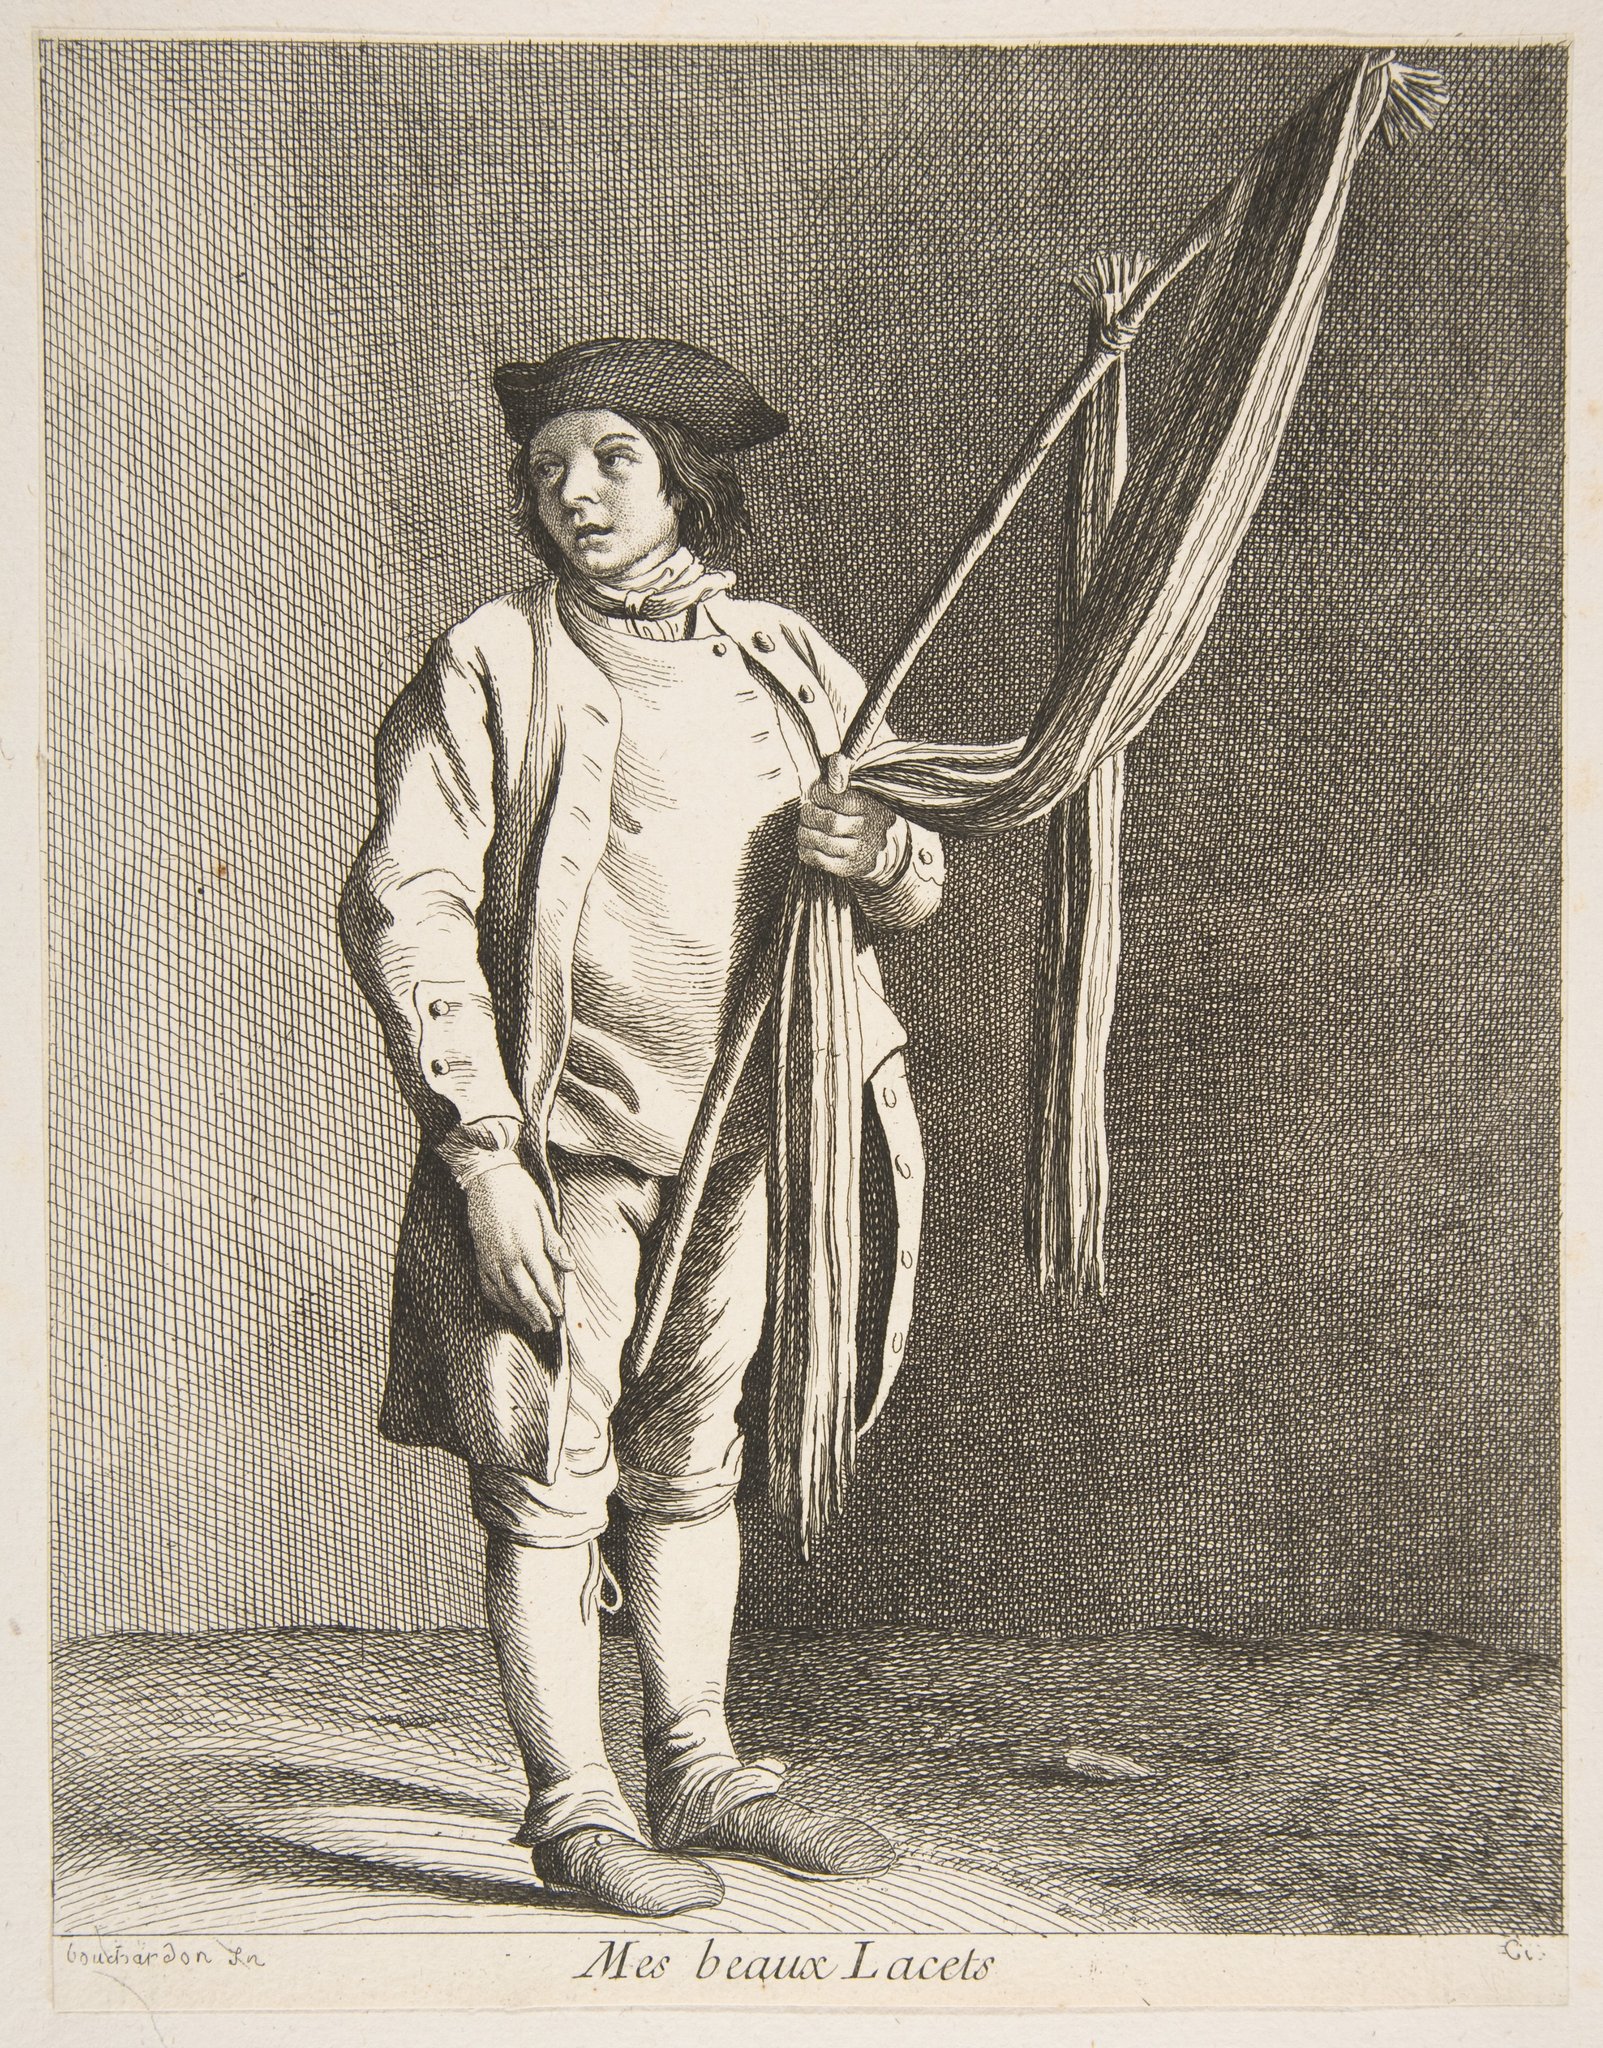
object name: print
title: Laces Peddler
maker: anne claude philippe de tubières, comte de caylus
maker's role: artist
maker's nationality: french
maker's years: 1692-1765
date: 1738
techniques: engraving, etching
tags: men